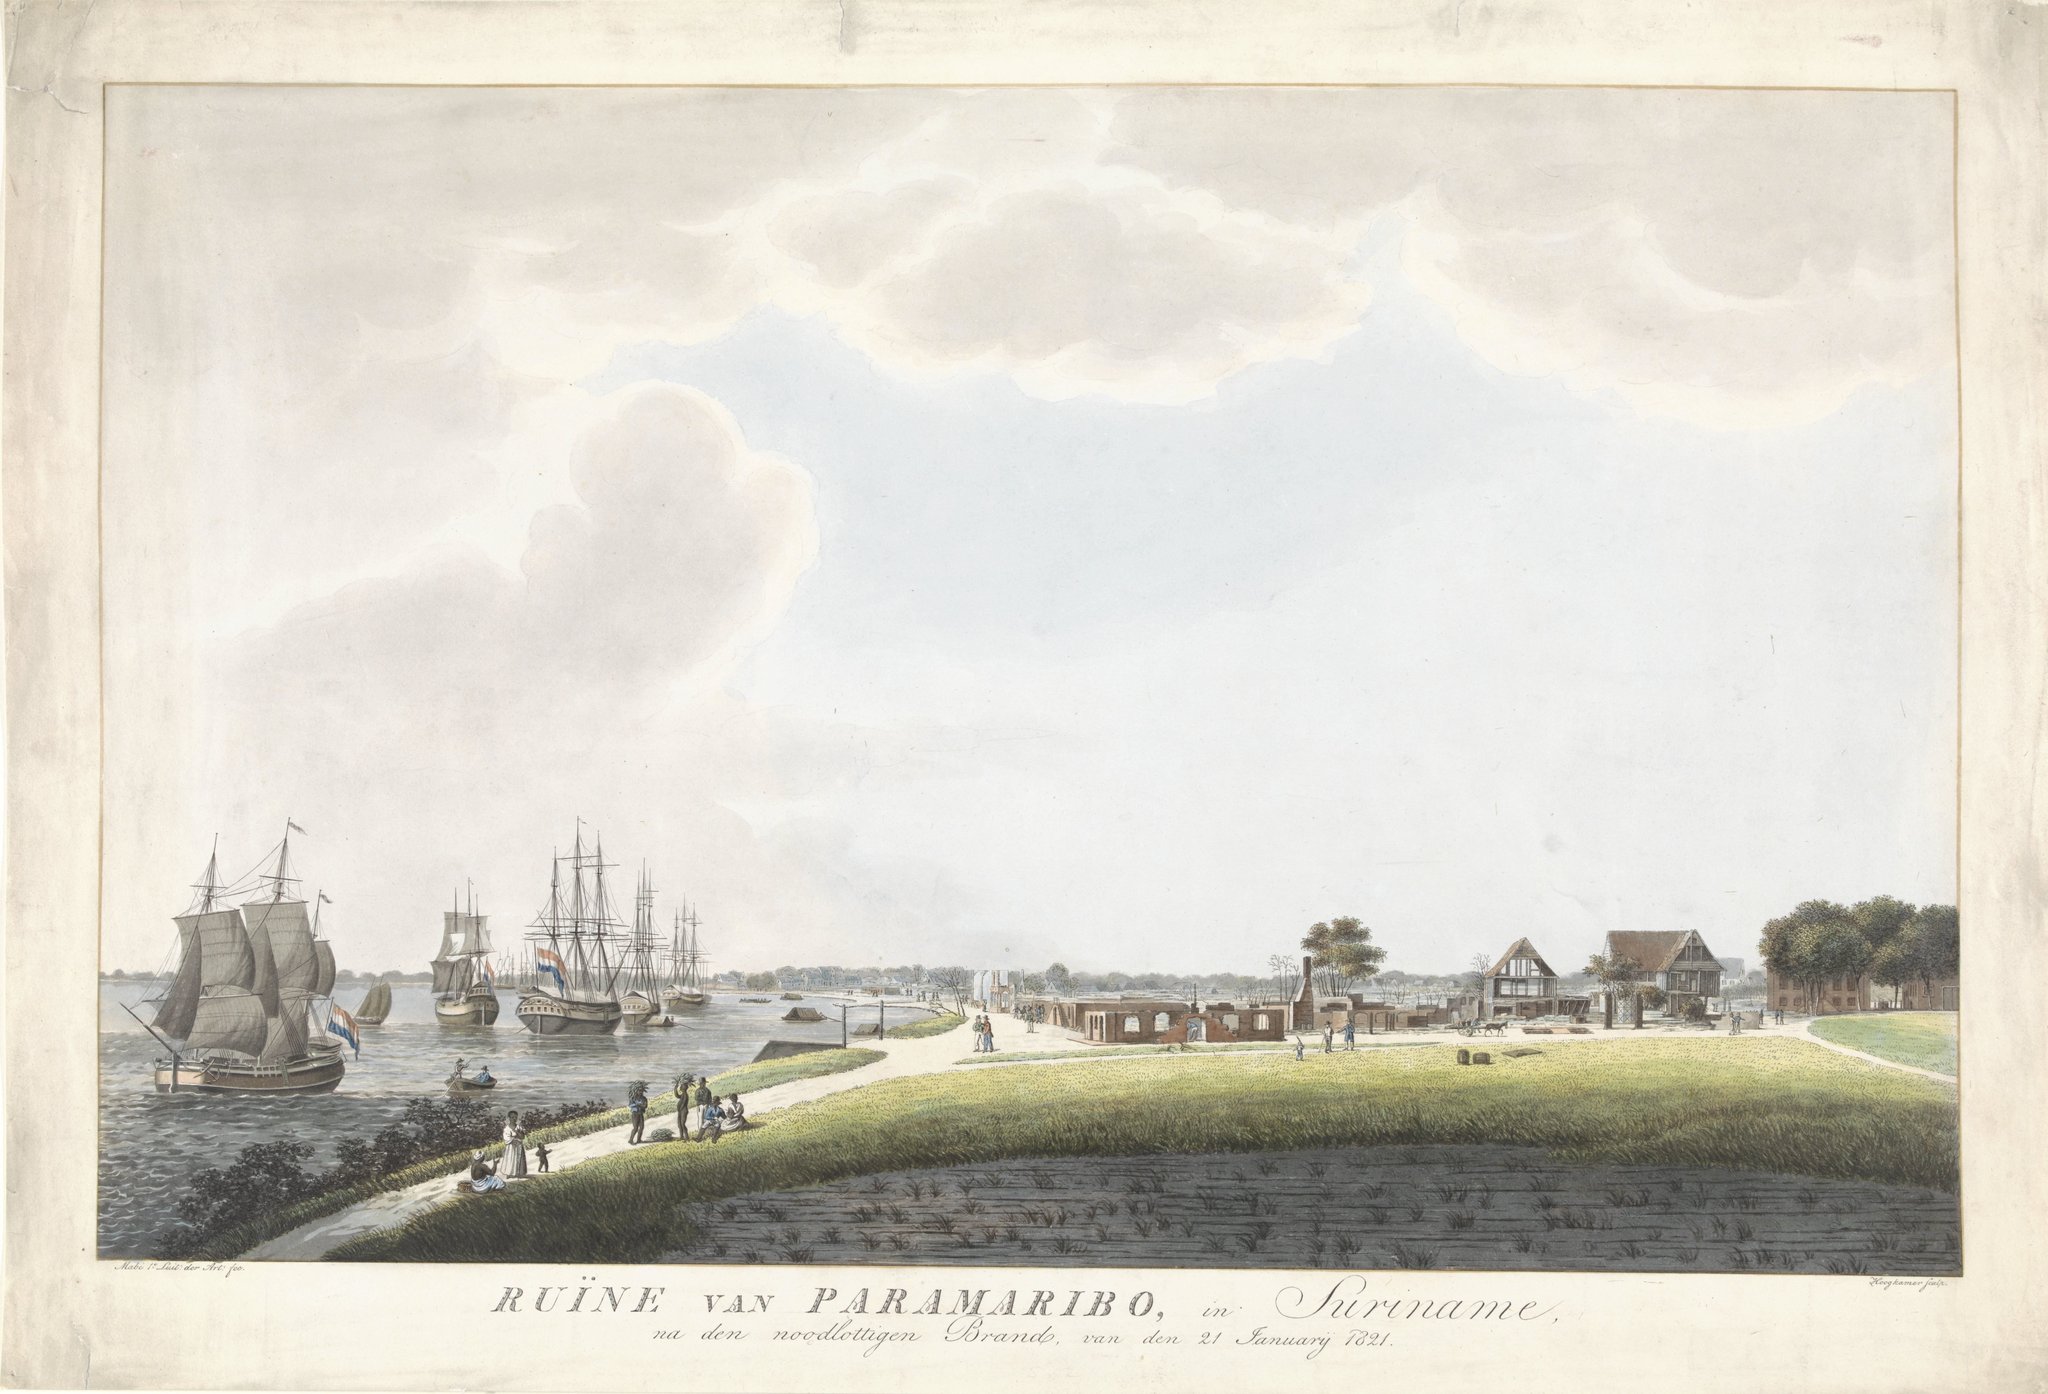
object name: print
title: Gezicht op uitgebrande huizen in Paramaribo, 1821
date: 1821-1823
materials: paper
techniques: aquatint, etching, hand coloring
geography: netherlands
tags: sailing-ship, sailing-boat, landscape with ruins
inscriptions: collector's mark: Lugt 2228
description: Gezicht op uitgebrande huizen in Paramaribo na de grote brand van 21 januari 1821. Links enkele zeilschepen en converserende figuren.